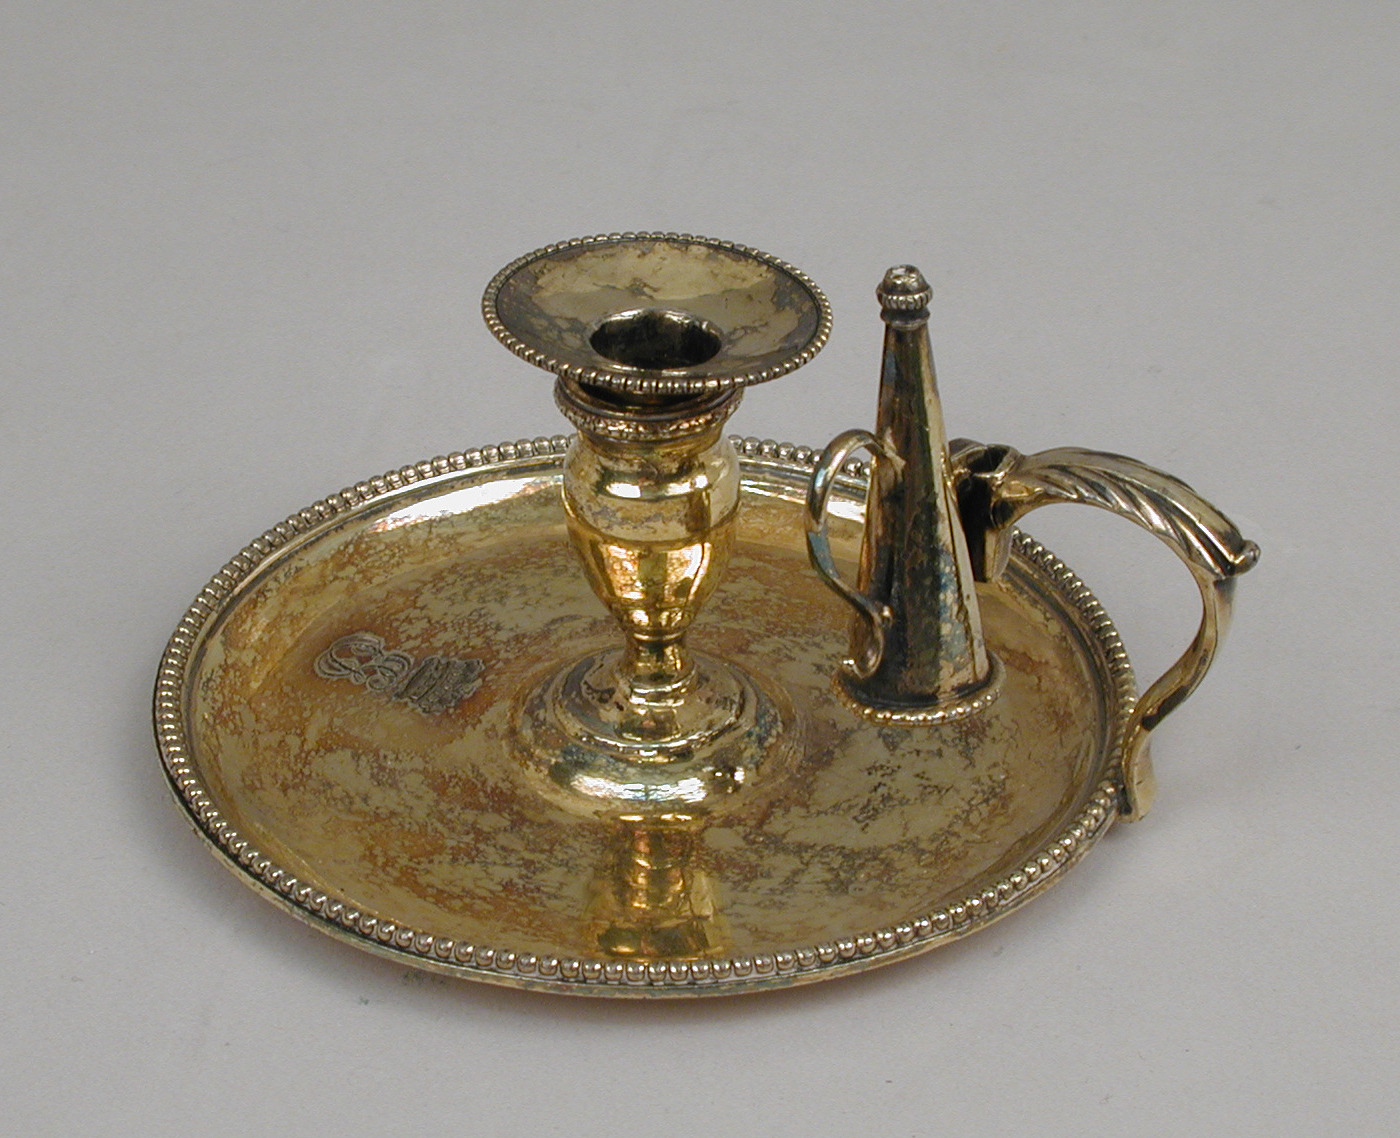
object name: taperstick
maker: samuel meriton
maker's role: maker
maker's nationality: british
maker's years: 1739-1839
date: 1778-1779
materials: silver gilt